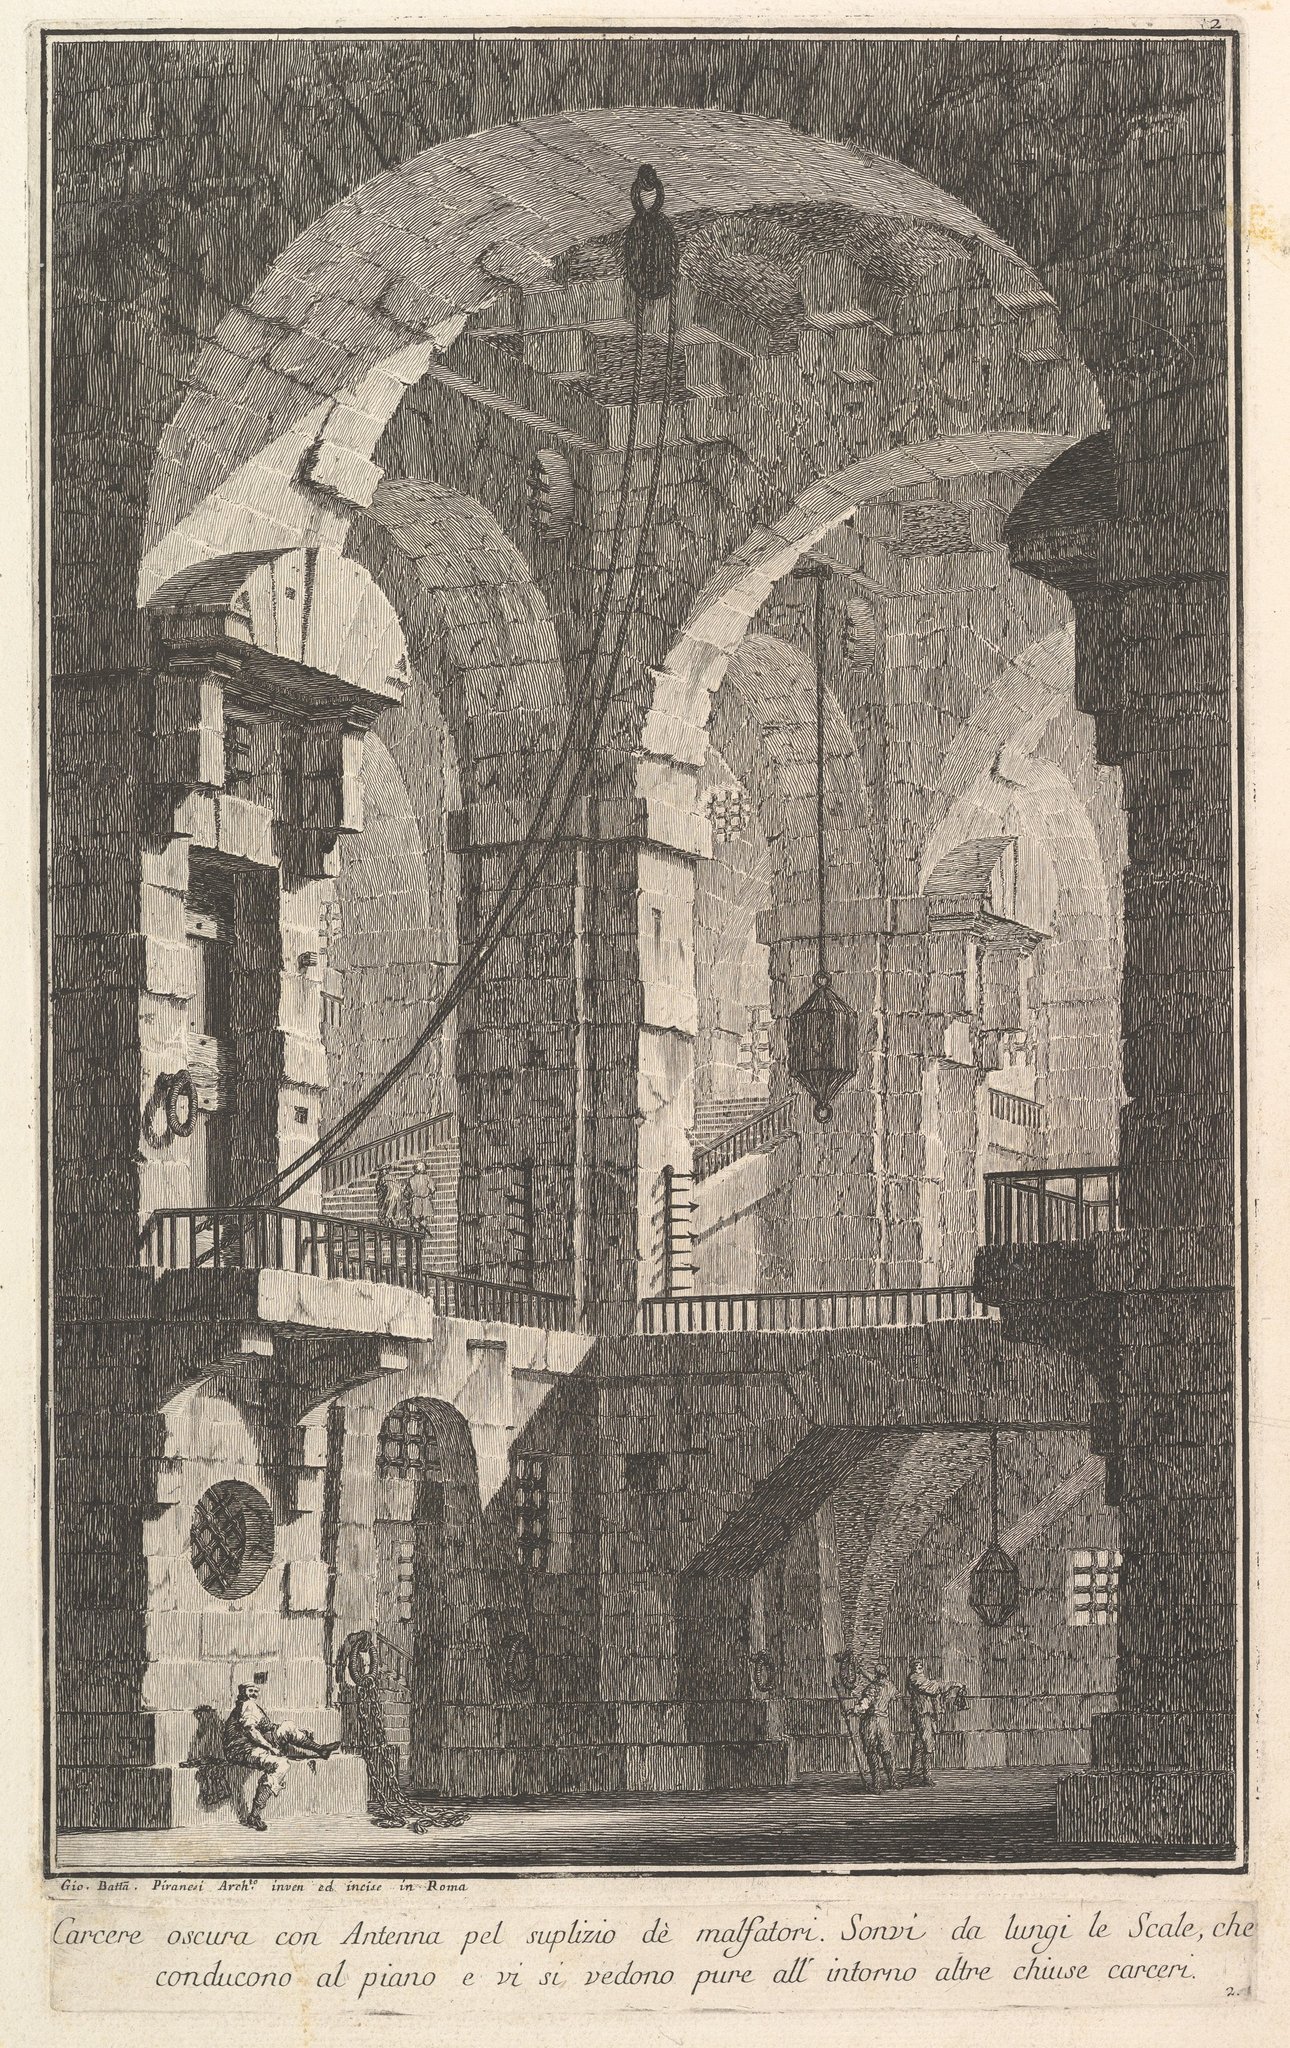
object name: print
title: Dark prison with a courtyard for the punishment of criminals... (Carcere oscura con Antenna pel suplizio dè malfatori...), from "Prima Parte di Architettura, e Prospettive"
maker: giovanni battista piranesi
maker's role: artist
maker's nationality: italian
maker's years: 1720-1778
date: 1750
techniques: etching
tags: prisons,courtyards